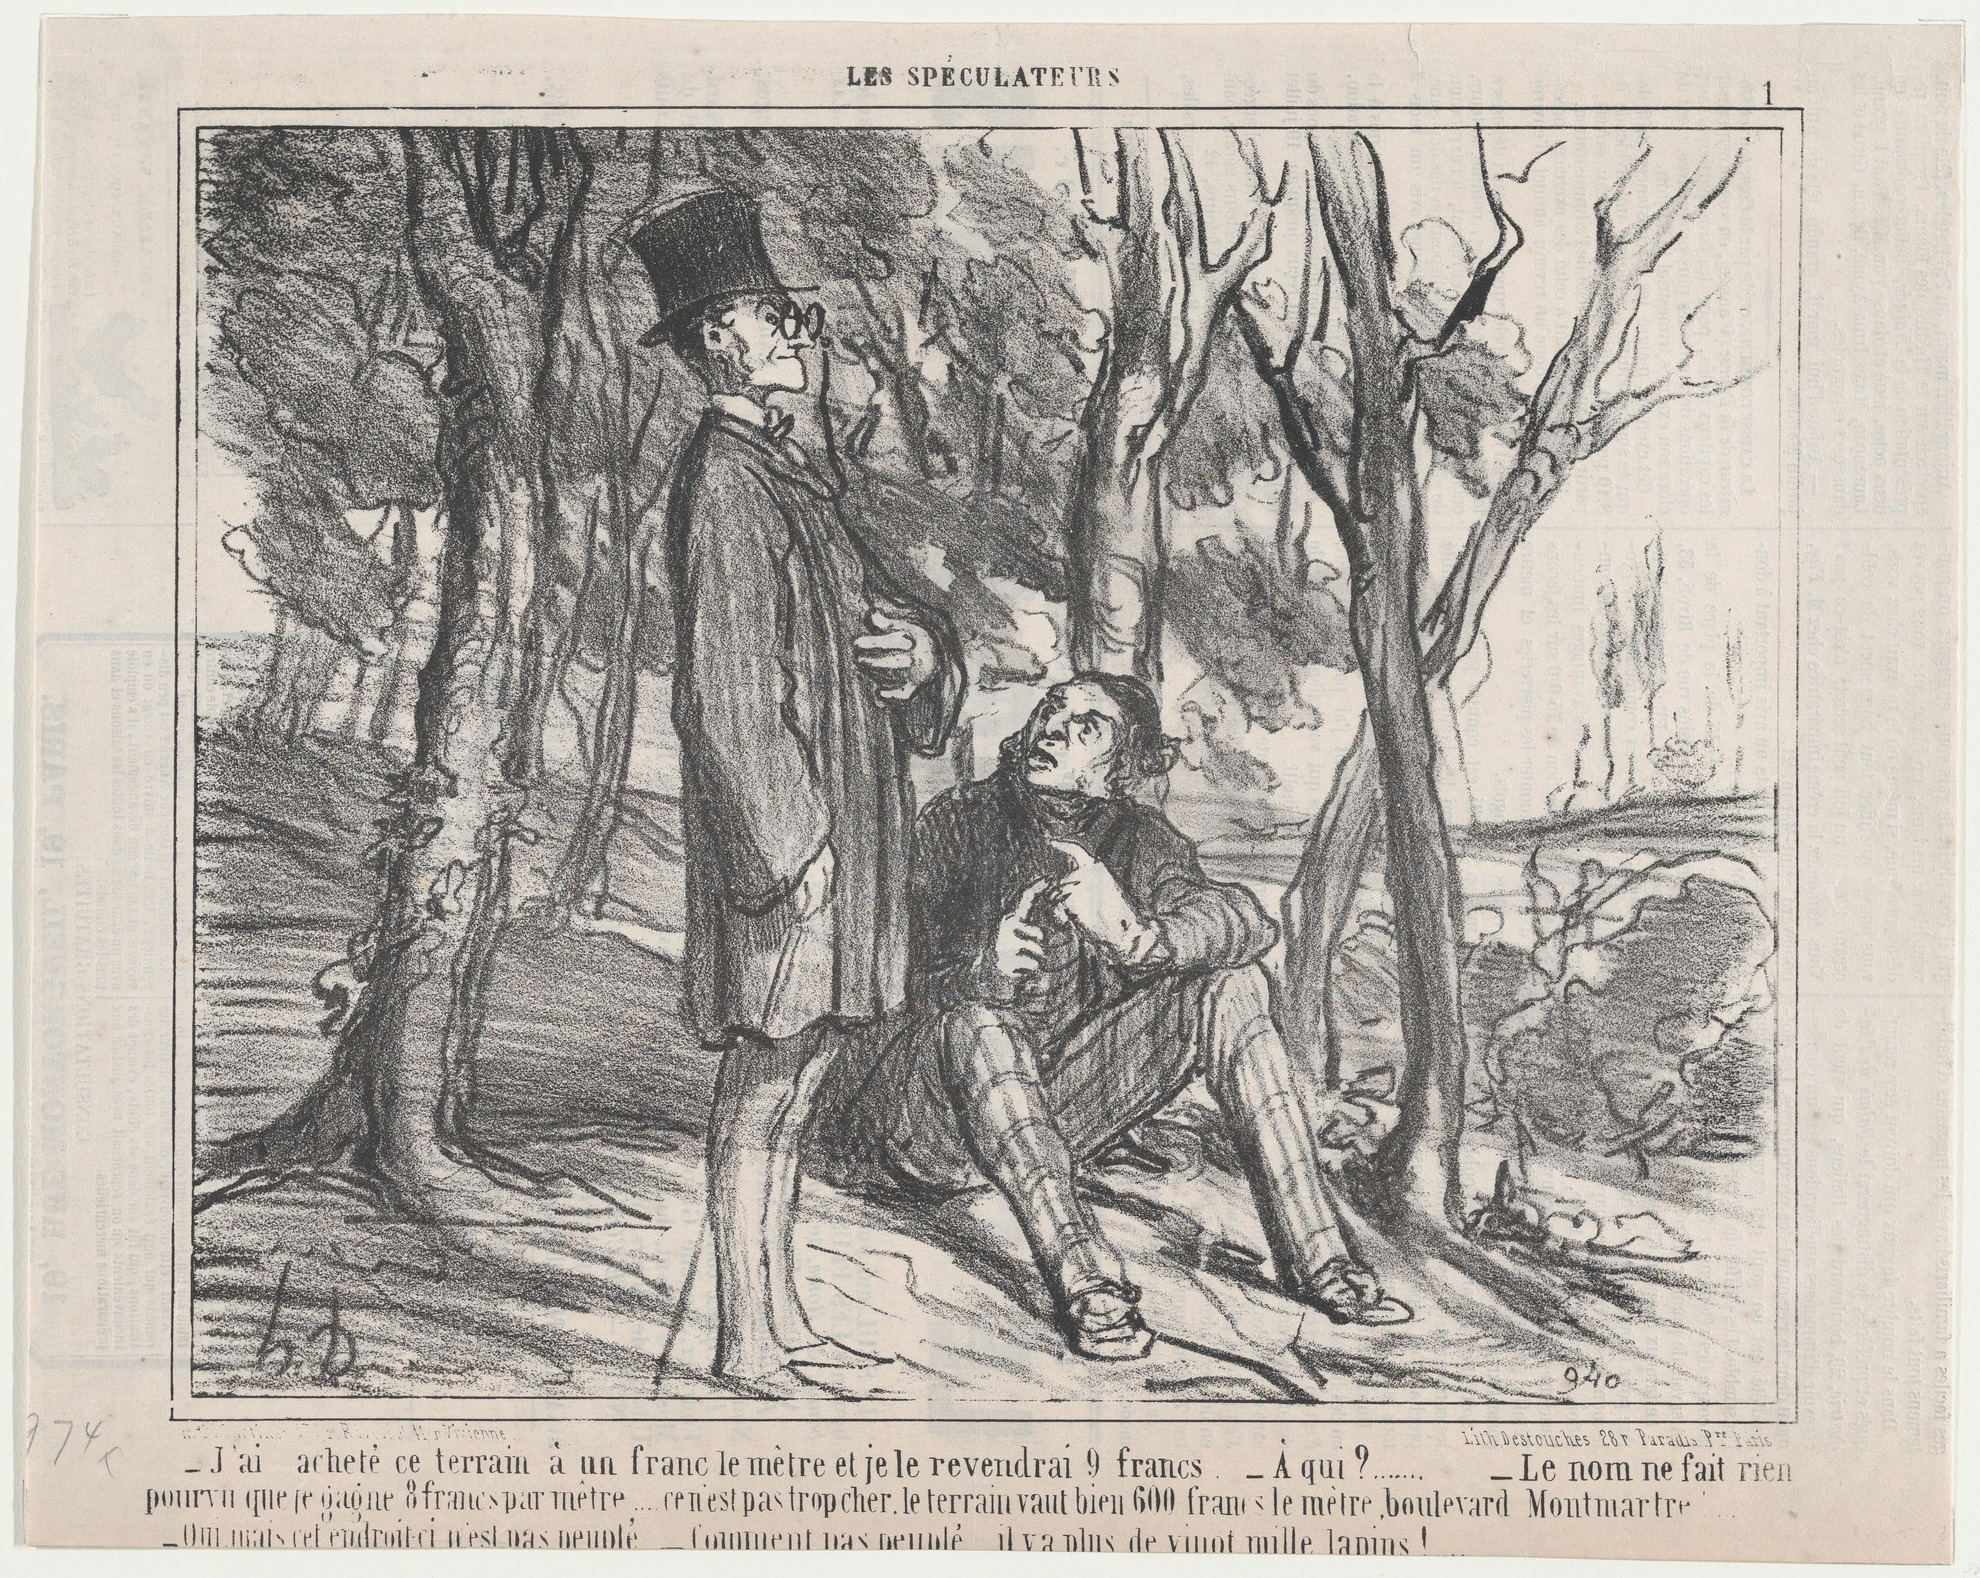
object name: print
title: J'ai acheté ce terrain à un franc..., from Les Spéculateurs, published in Le Charivari, July 7, 1857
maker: honoré daumier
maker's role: artist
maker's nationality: french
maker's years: 1808-1879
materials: paper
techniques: lithograph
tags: men,trees